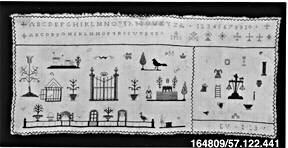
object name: sampler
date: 1823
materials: linen, silk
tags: birds,gates